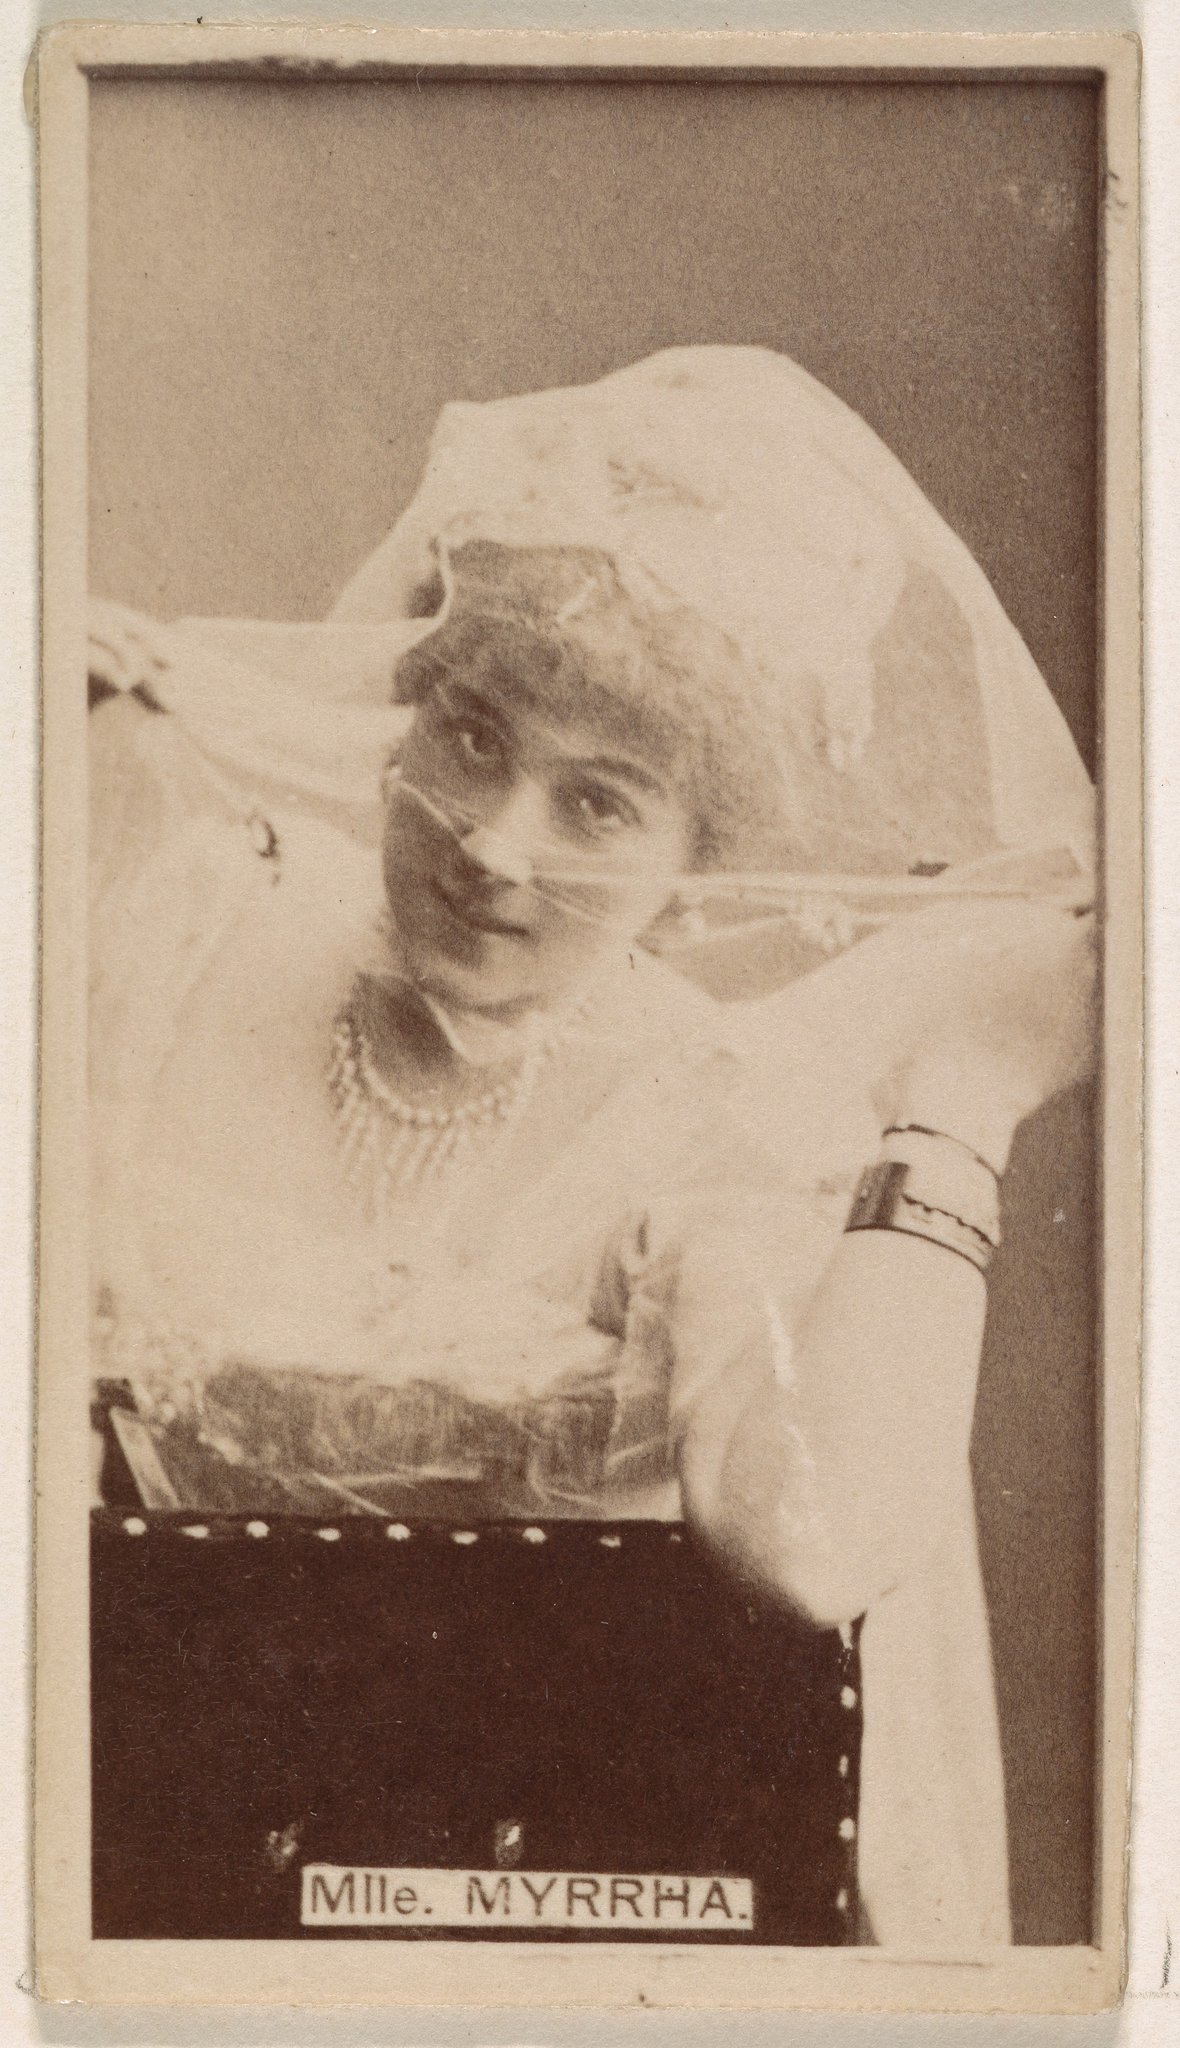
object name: photograph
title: Mlle. Myrrha, from the Actresses series (N245) issued by Kinney Brothers to promote Sweet Caporal Cigarettes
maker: kinney brothers tobacco company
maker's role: publisher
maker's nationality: american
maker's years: 1869-2011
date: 1890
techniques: albumen silver print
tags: portraits,women,actresses